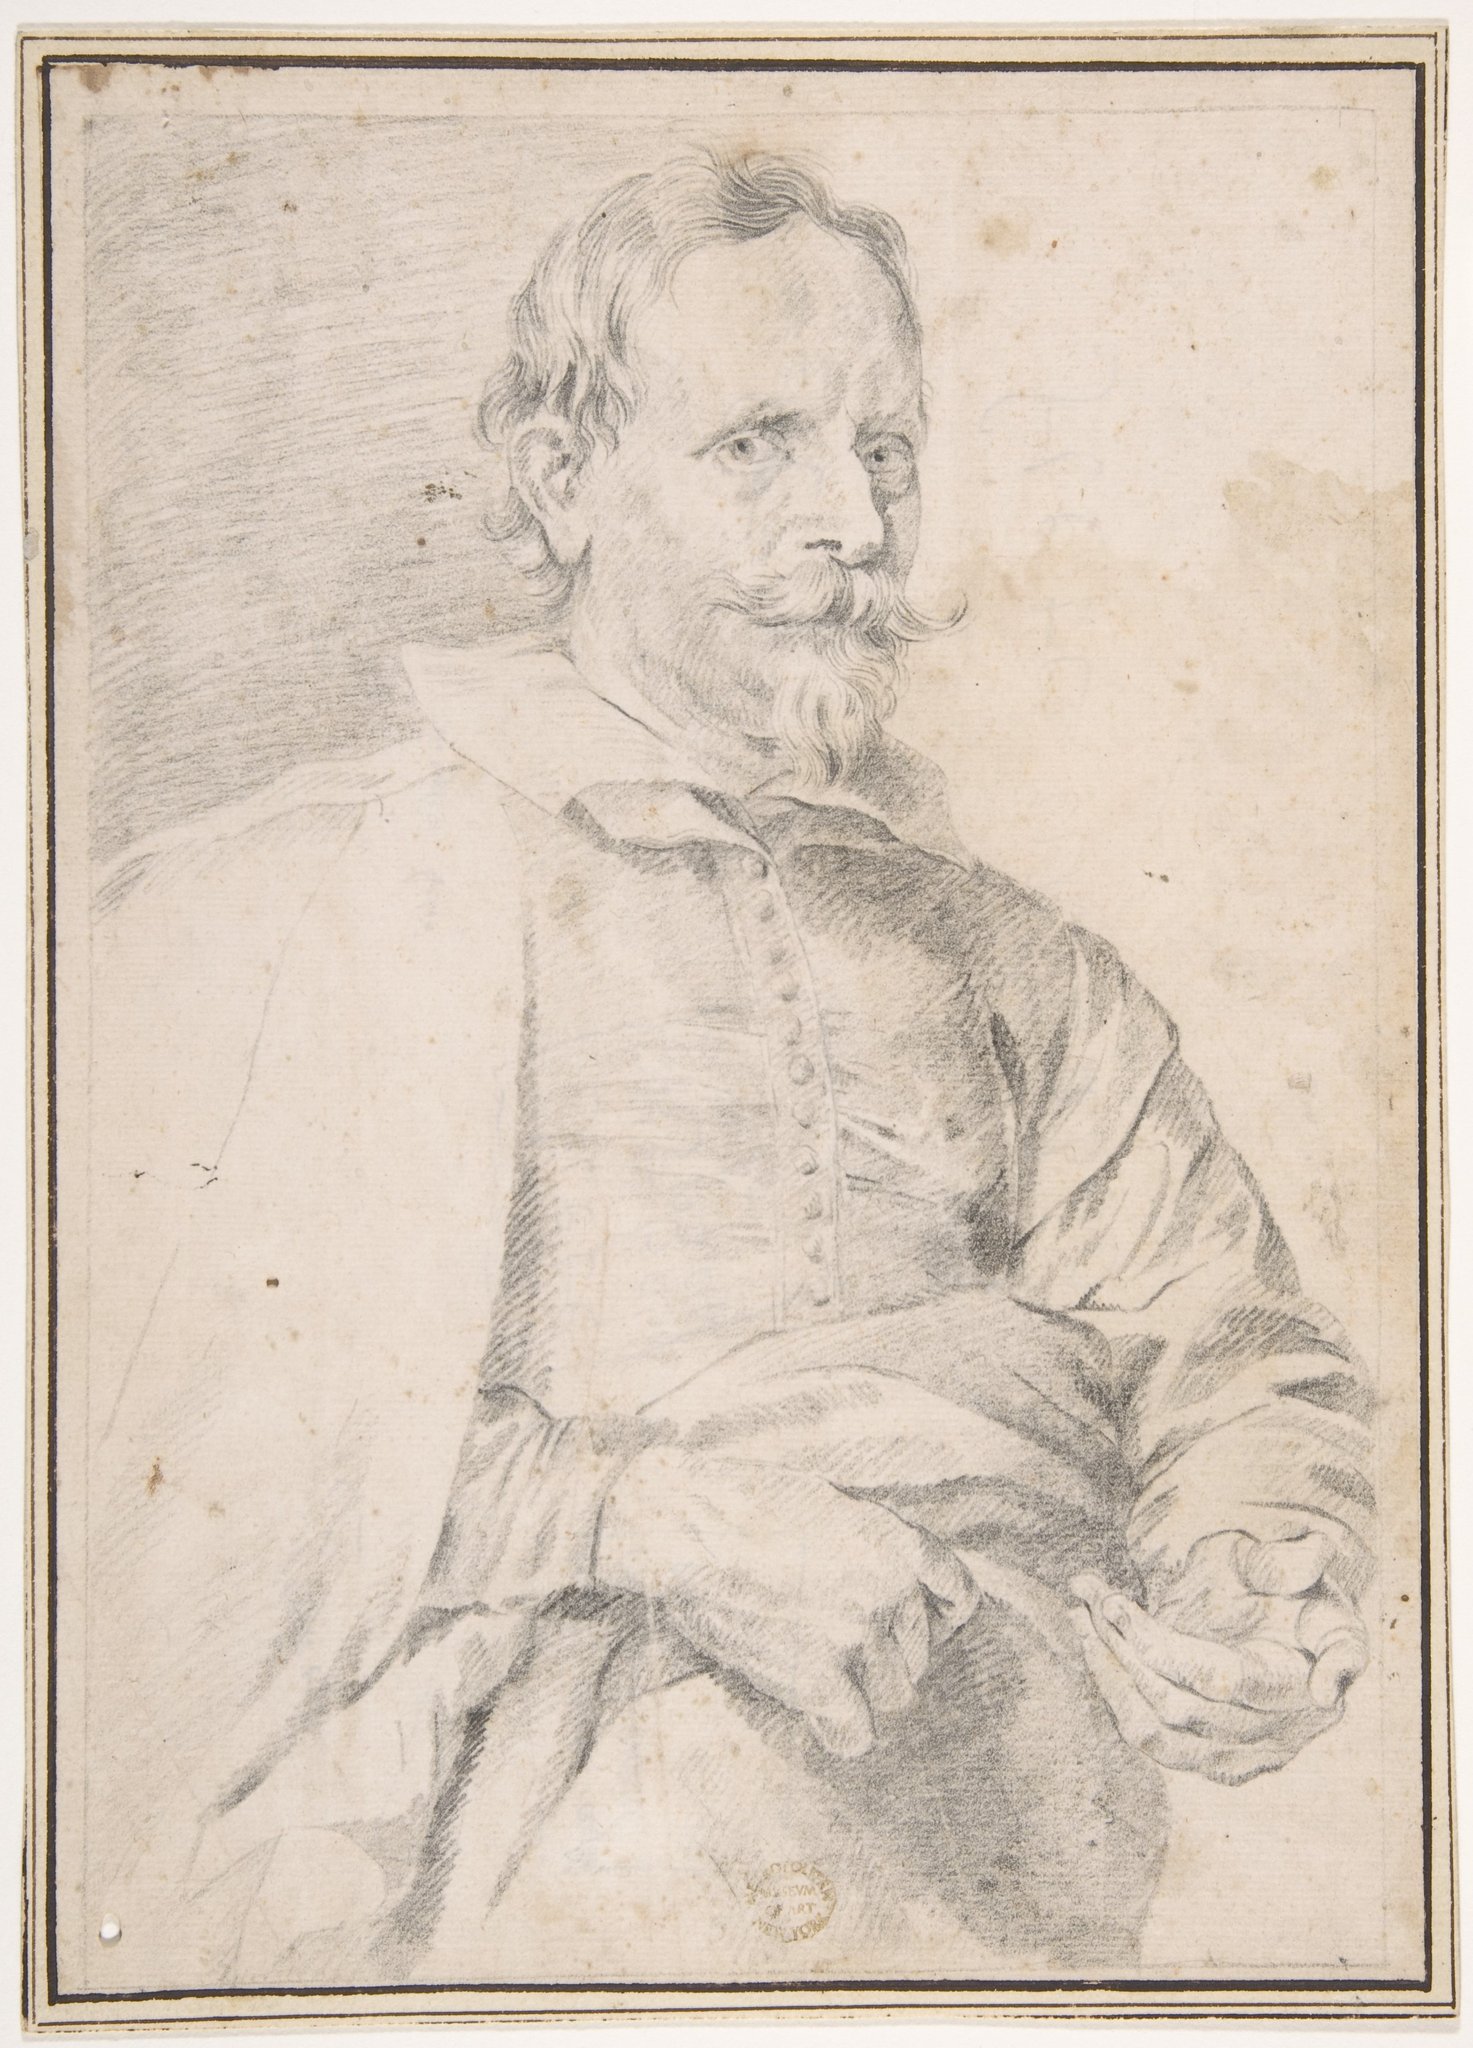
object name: drawing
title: Portrait of Cornelis de Vos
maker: anonymous, flemish, 17th century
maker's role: artist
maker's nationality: flemish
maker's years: 1600-1700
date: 1501-1600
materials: chalk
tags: men,portraits